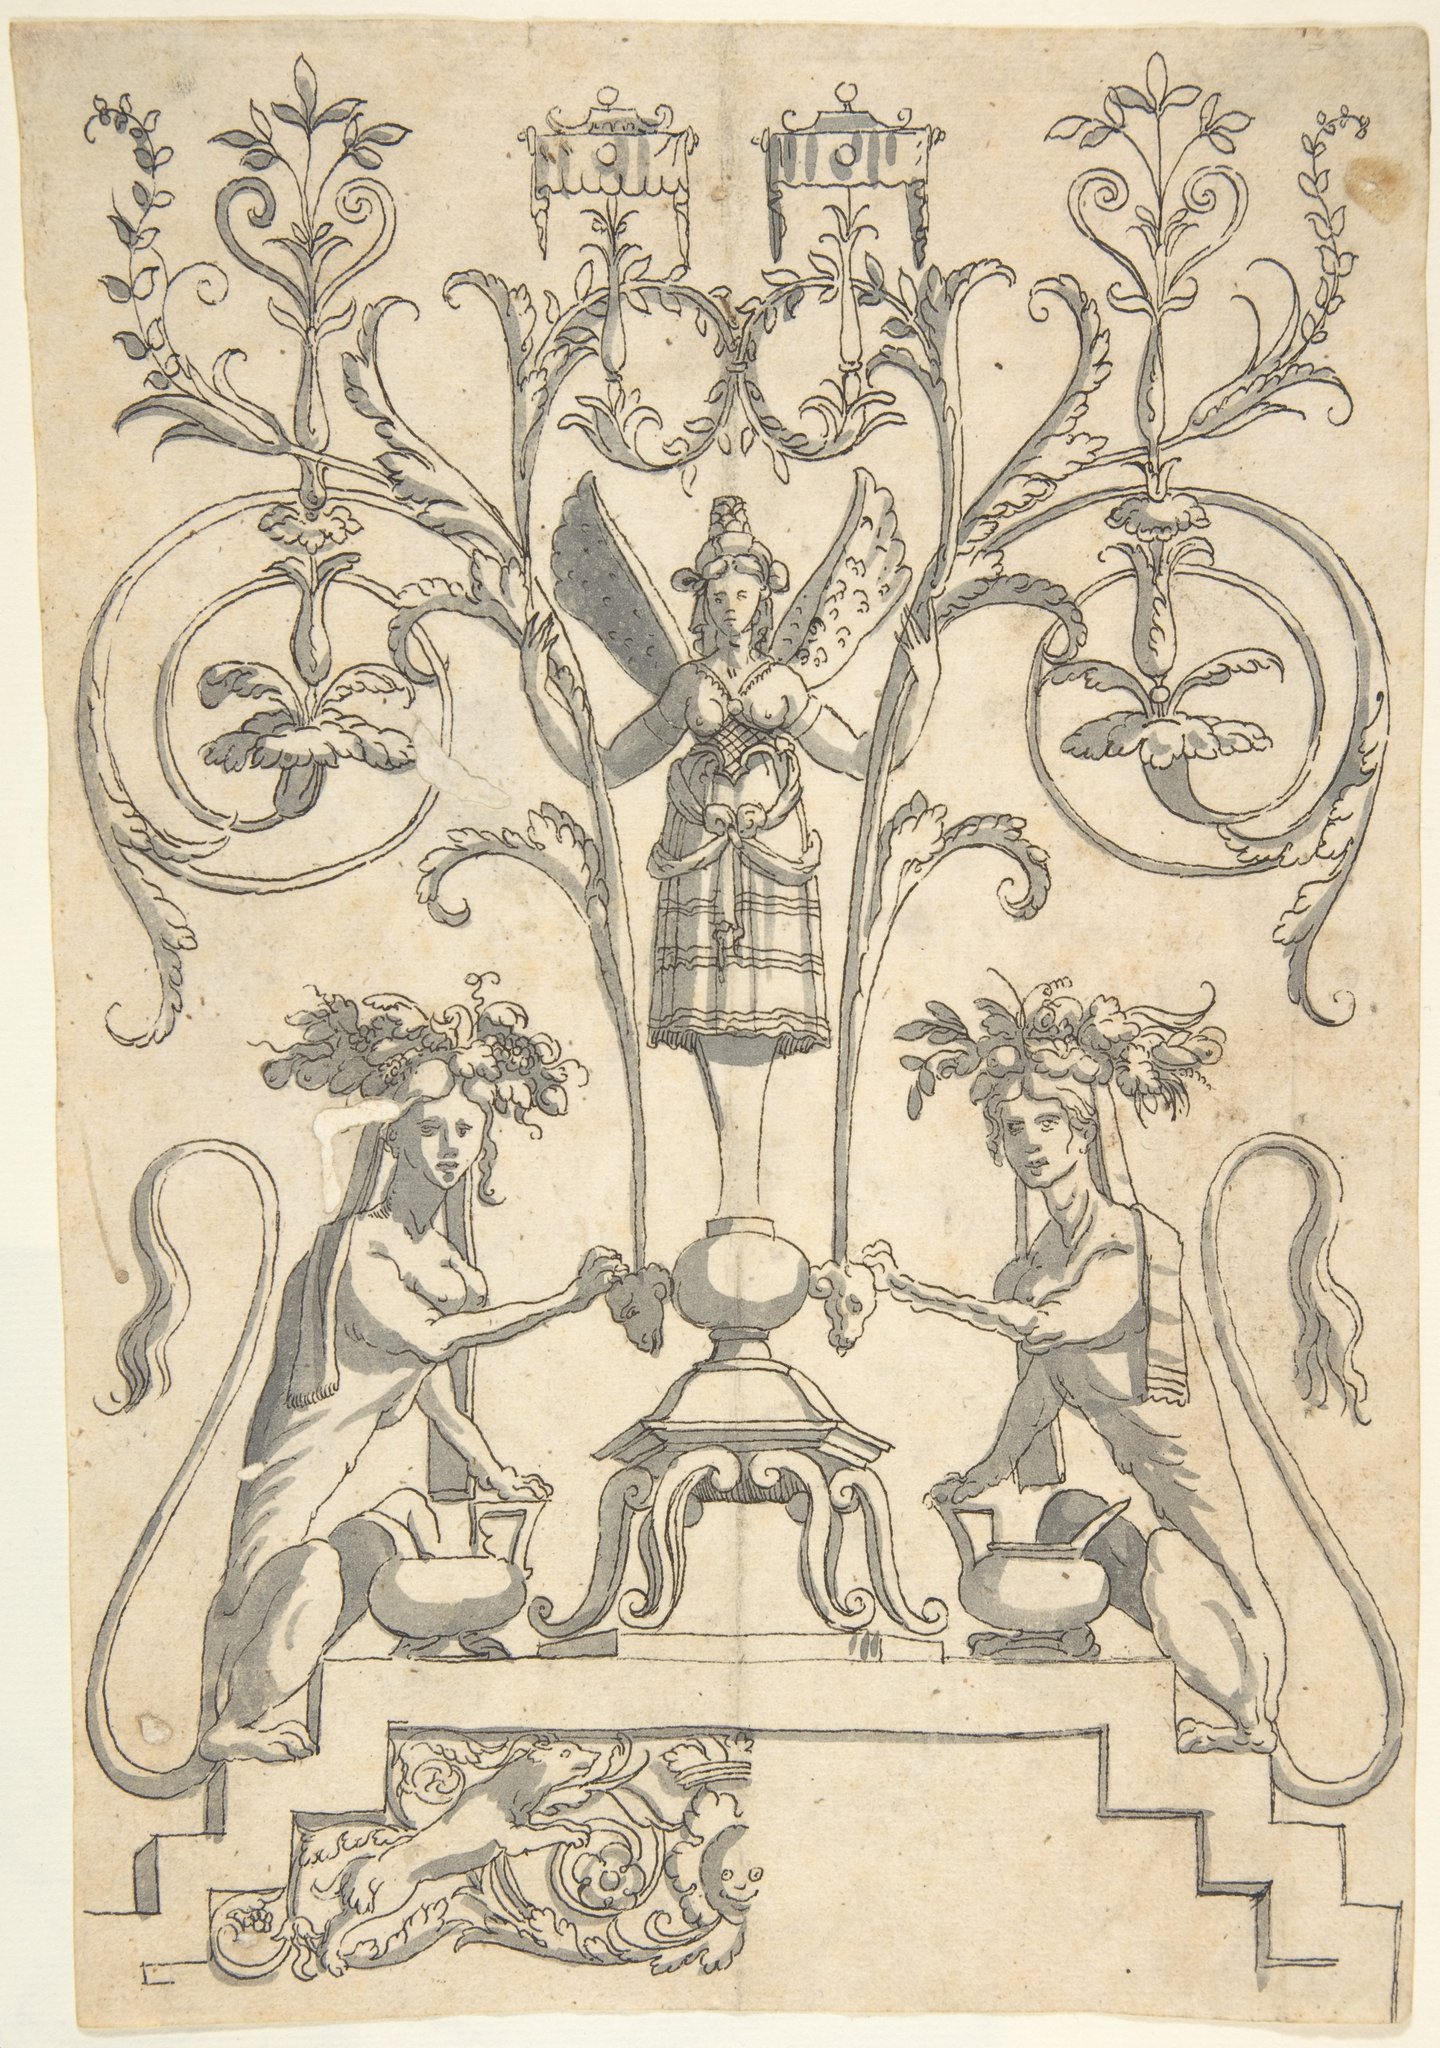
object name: ornament architecture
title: Candelabra Grotesque with a Winged Female Term on a Pedestal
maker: anonymous, italian, 16th century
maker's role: artist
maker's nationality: italian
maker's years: 1500-1600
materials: ink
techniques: brush, pen, wash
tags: grotesques,ornament,mythical creatures